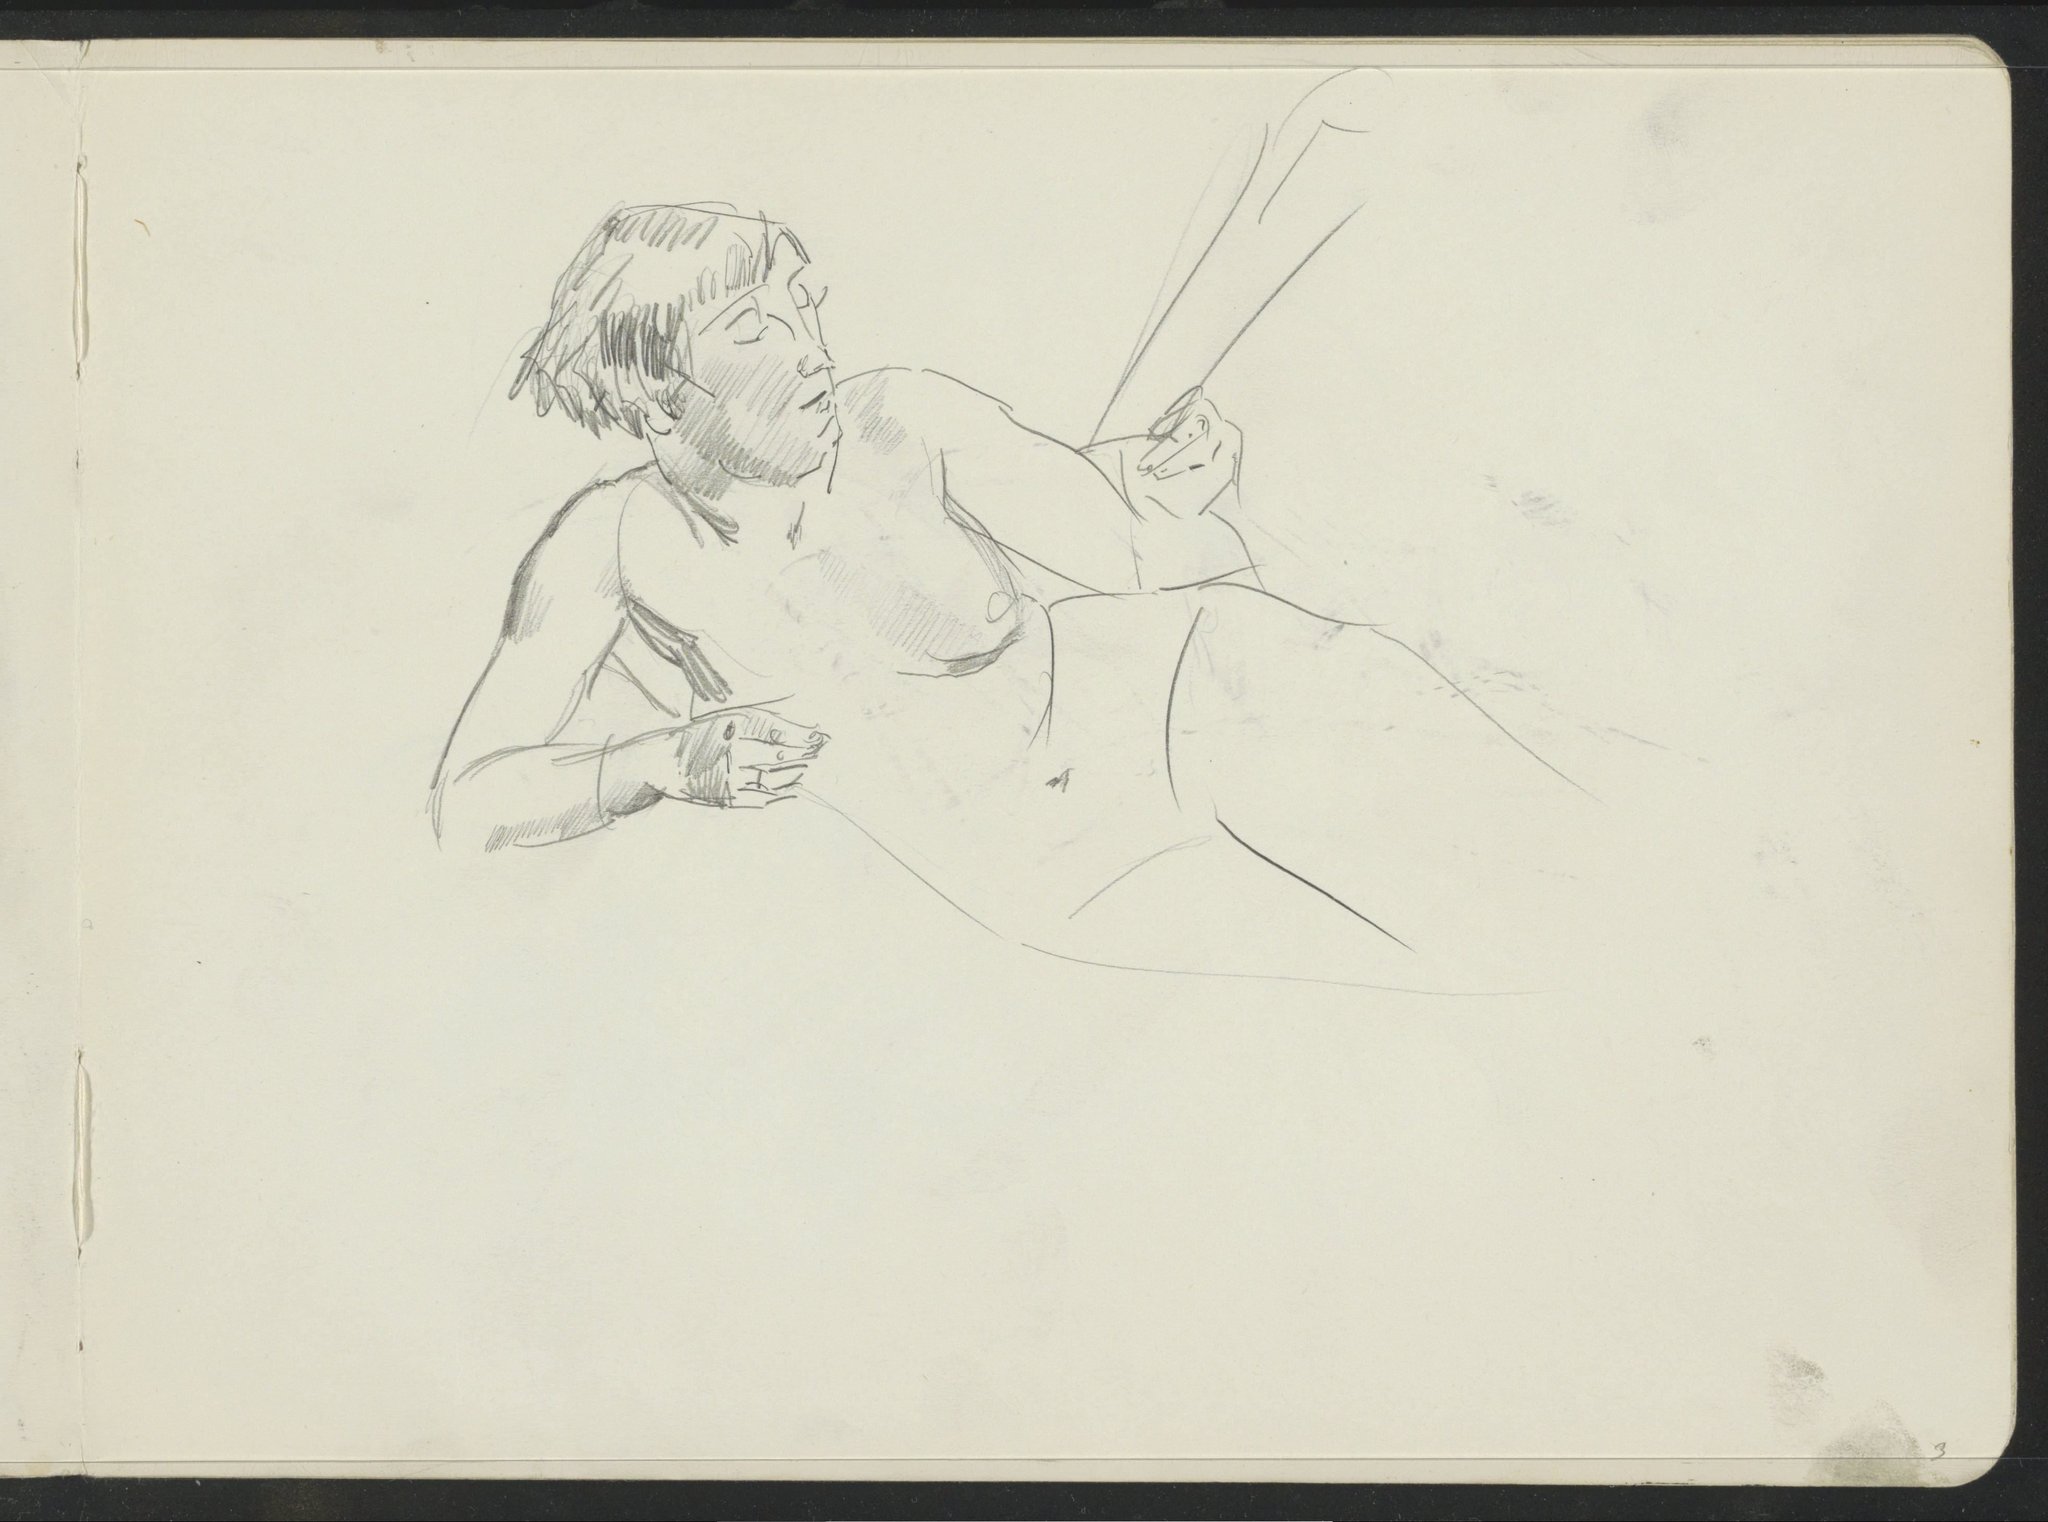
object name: sketchbook leaf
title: Reclining Female Nude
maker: isaac israels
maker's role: draughtsman, painter, print maker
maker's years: 1865-1934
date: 1915-1934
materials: paper, pencil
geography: the hague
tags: lying on one side, with uplifted upper part of the body and leaning on the arm - aa - female human figure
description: Ze leunt op haar rechterarm. Blad 3 recto uit schetsboek XV met 22 bladen.